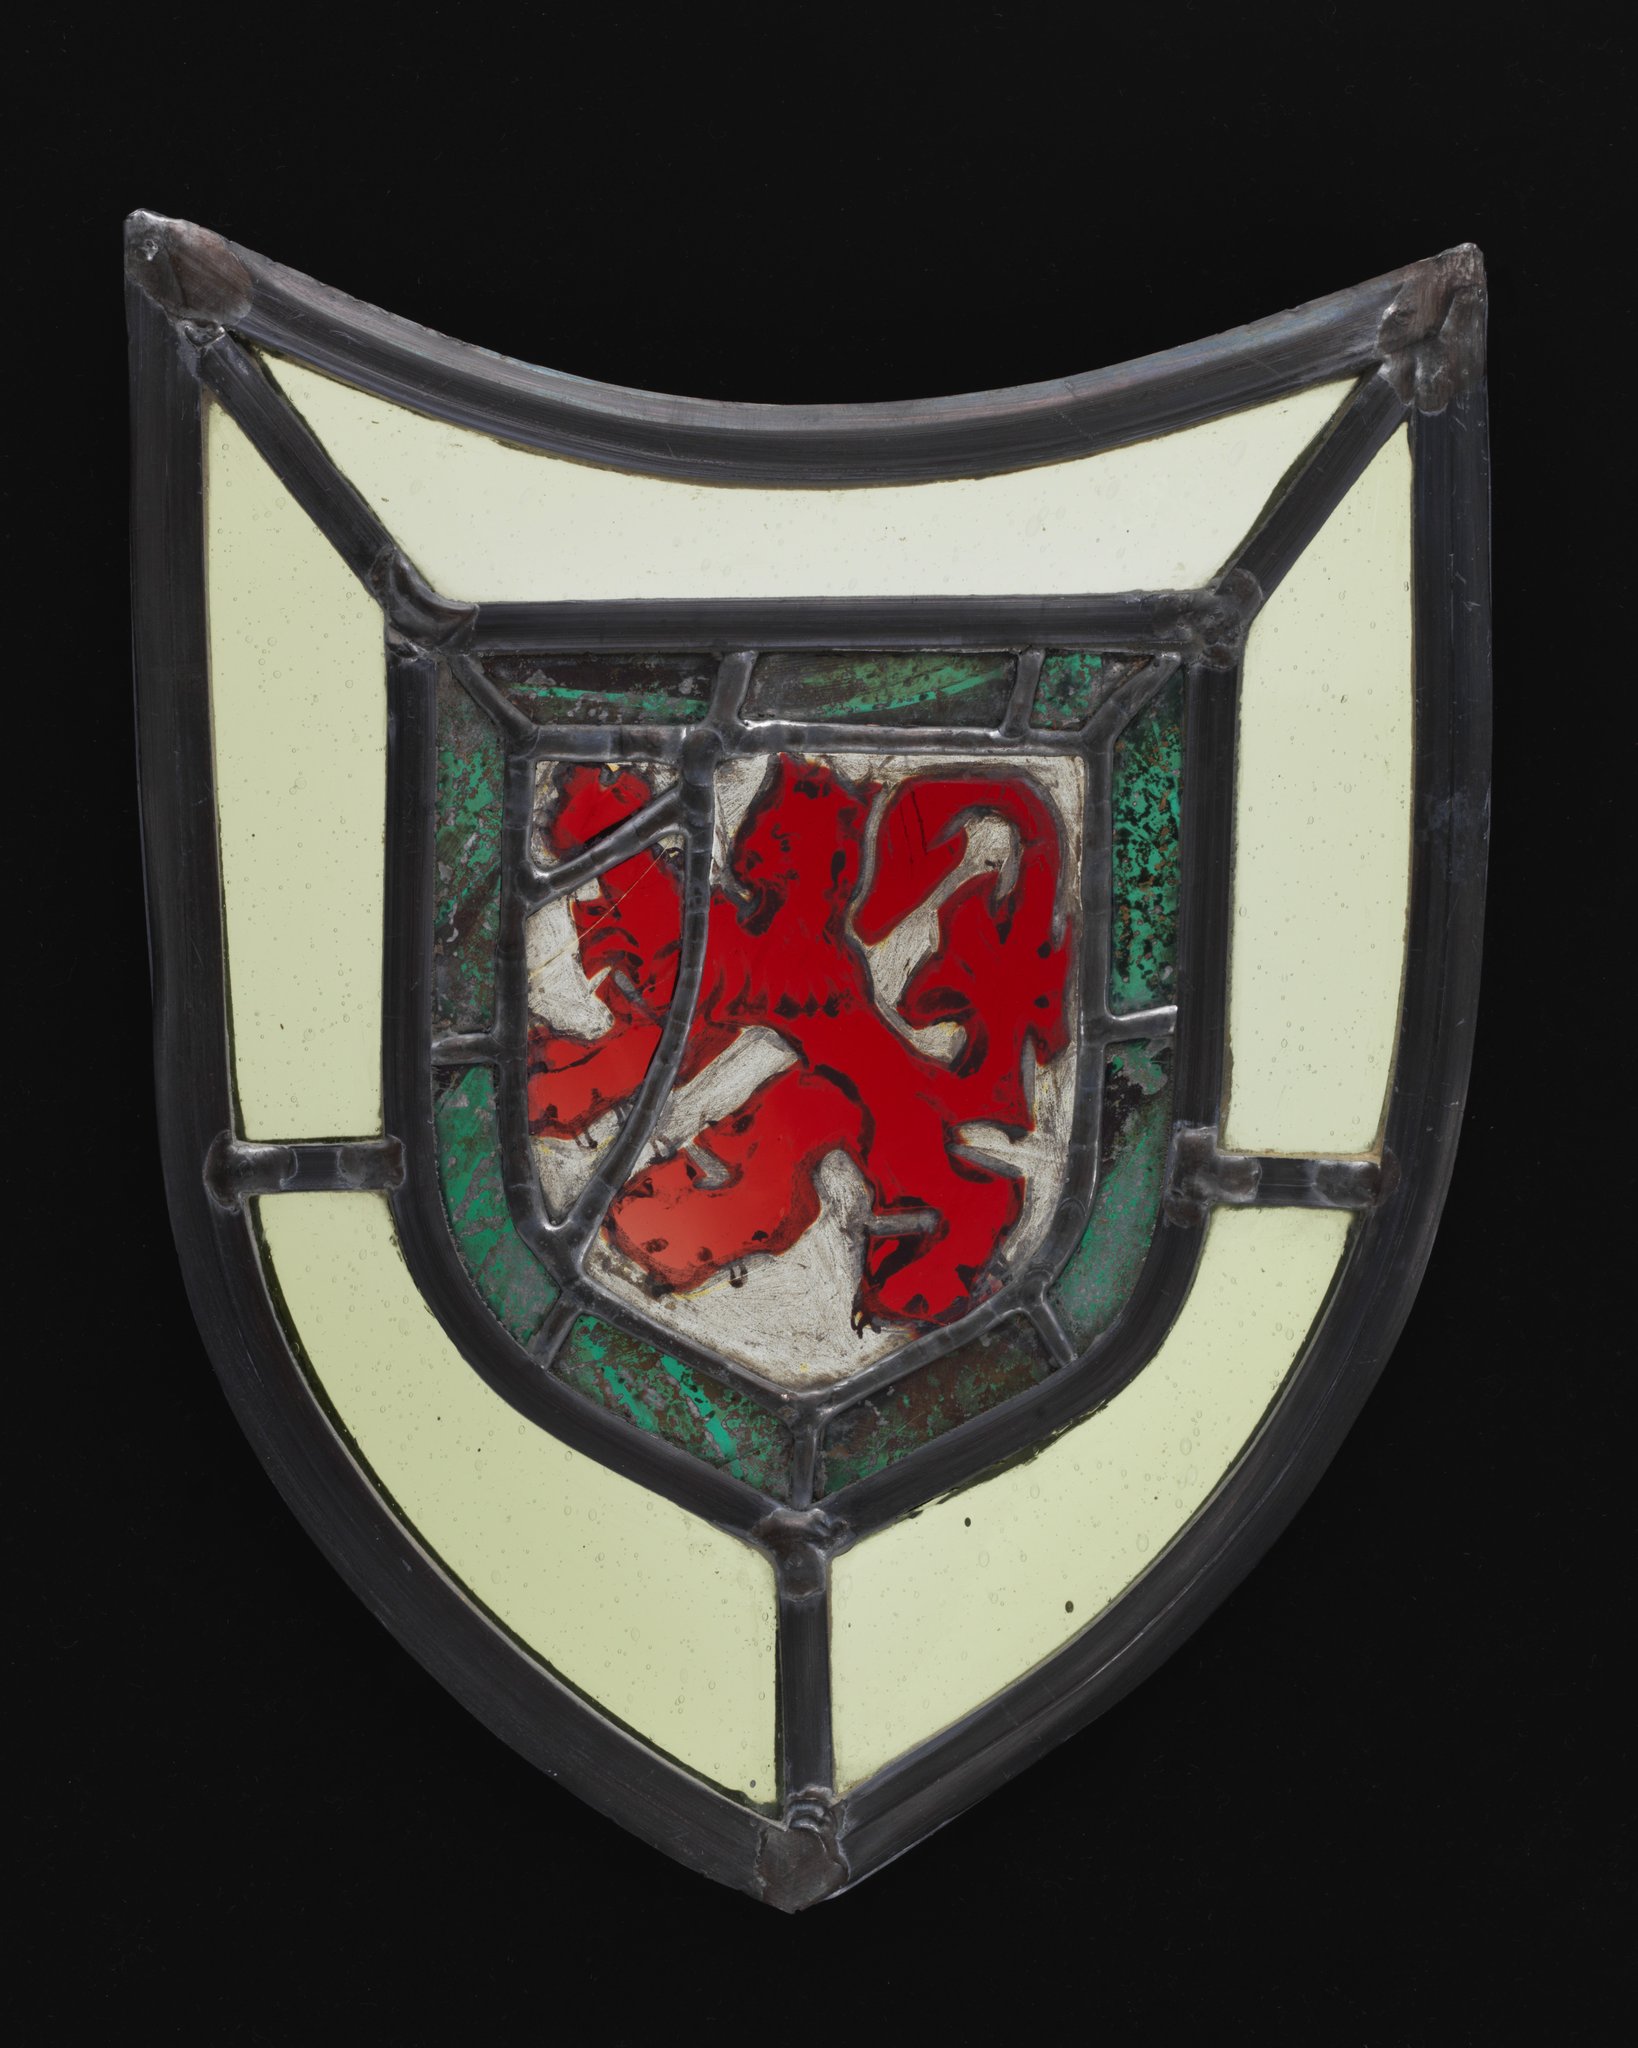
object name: panel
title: Heraldic shield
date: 1501-1600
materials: glass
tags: shields,lions